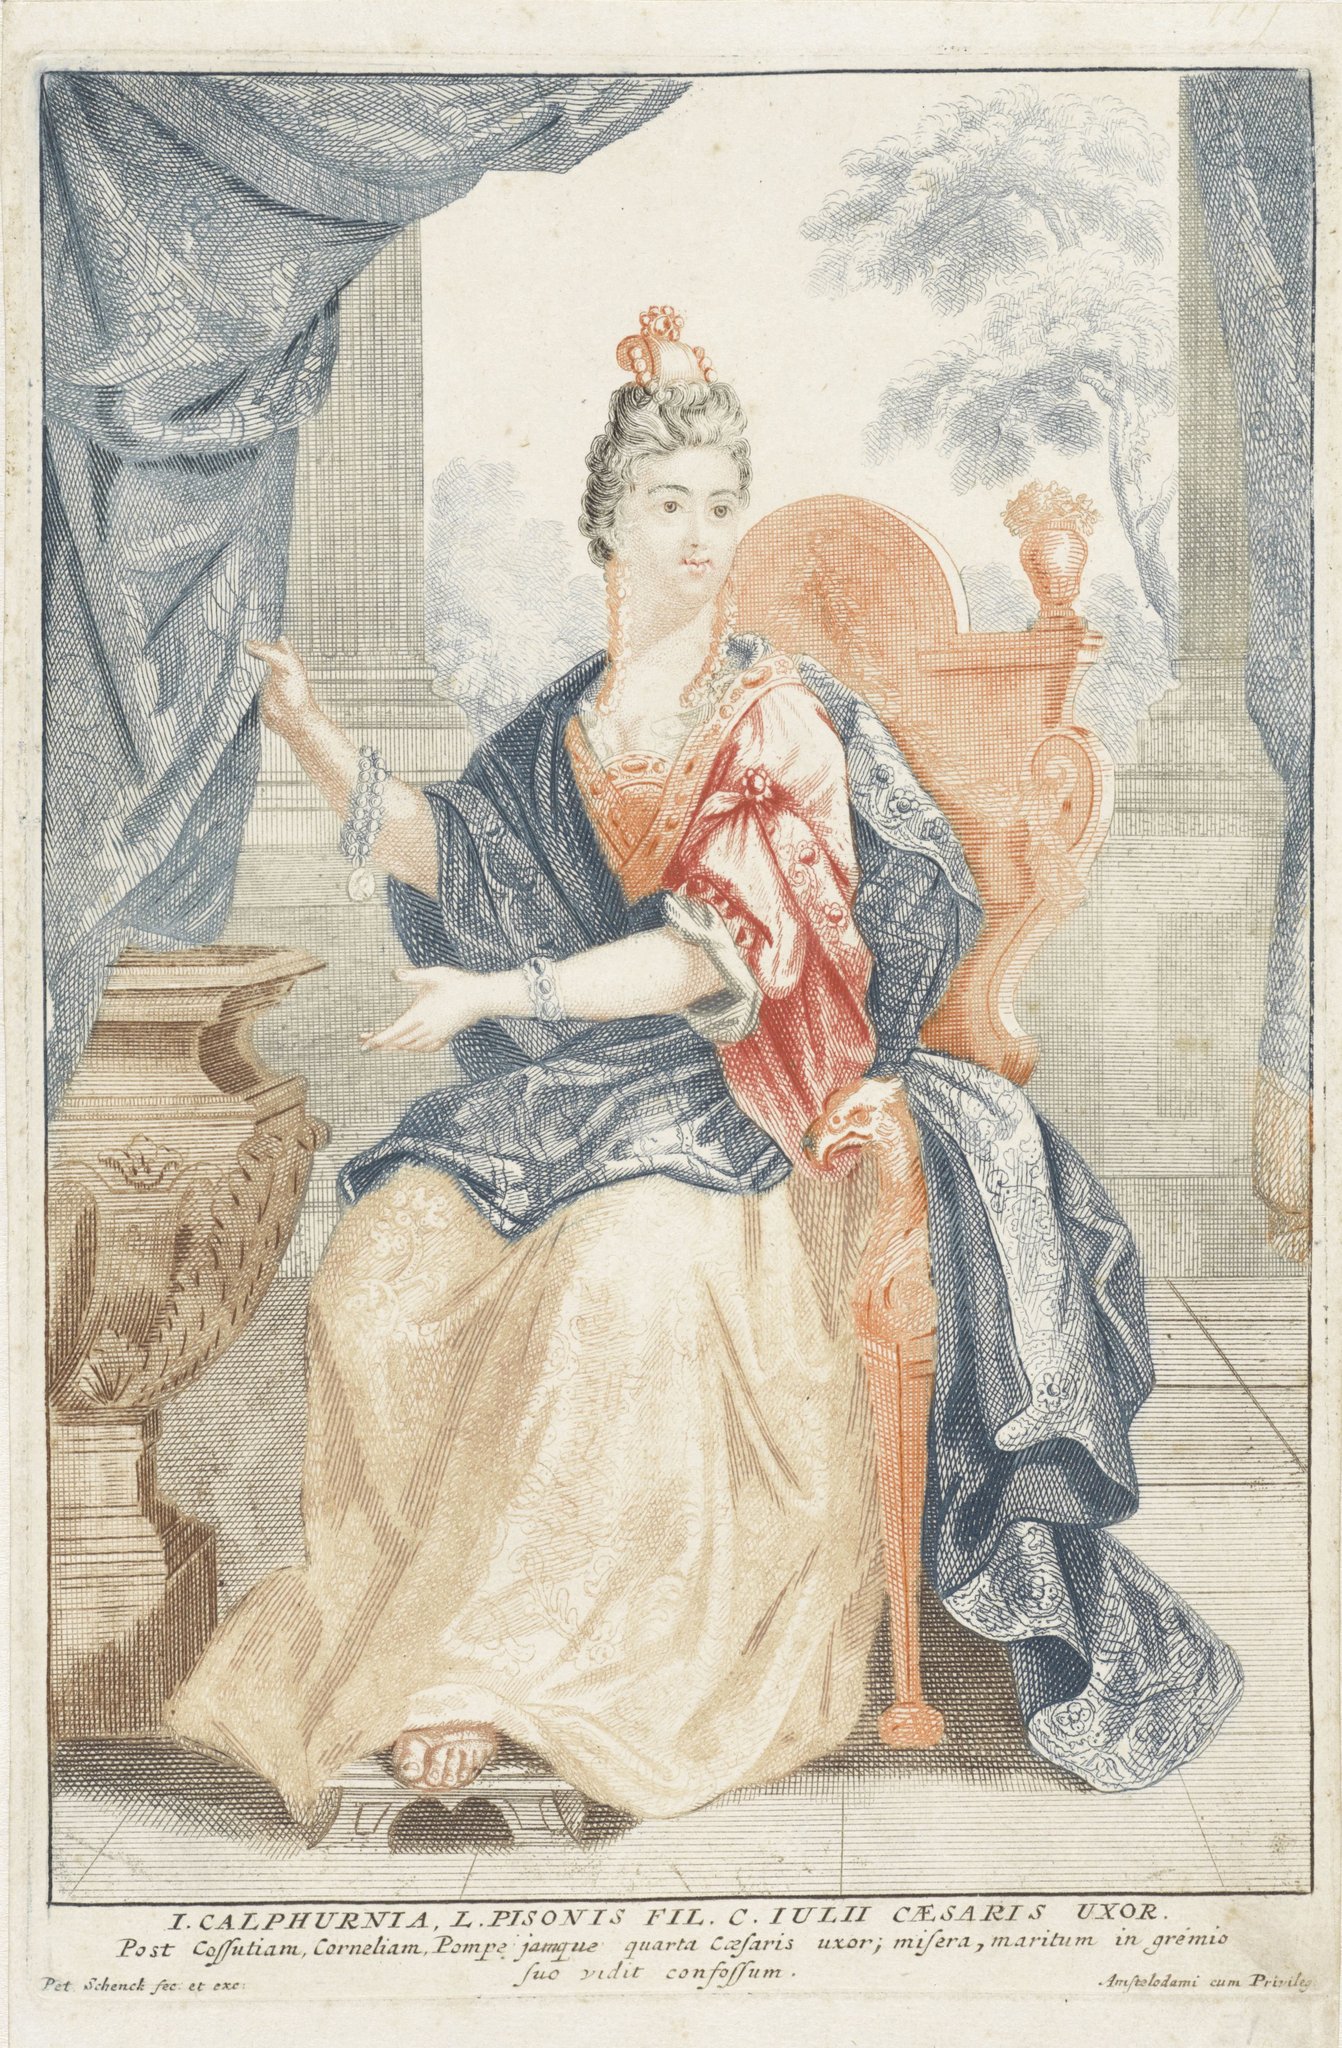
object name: print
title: Portret van Calpurnia Pisonis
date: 1675-1711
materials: paper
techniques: engraving, etching, lithography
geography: amsterdam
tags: family of a ruler, and court - bb - female ruler, necklace (+ women's clothes)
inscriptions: collector's mark: Lugt 2228